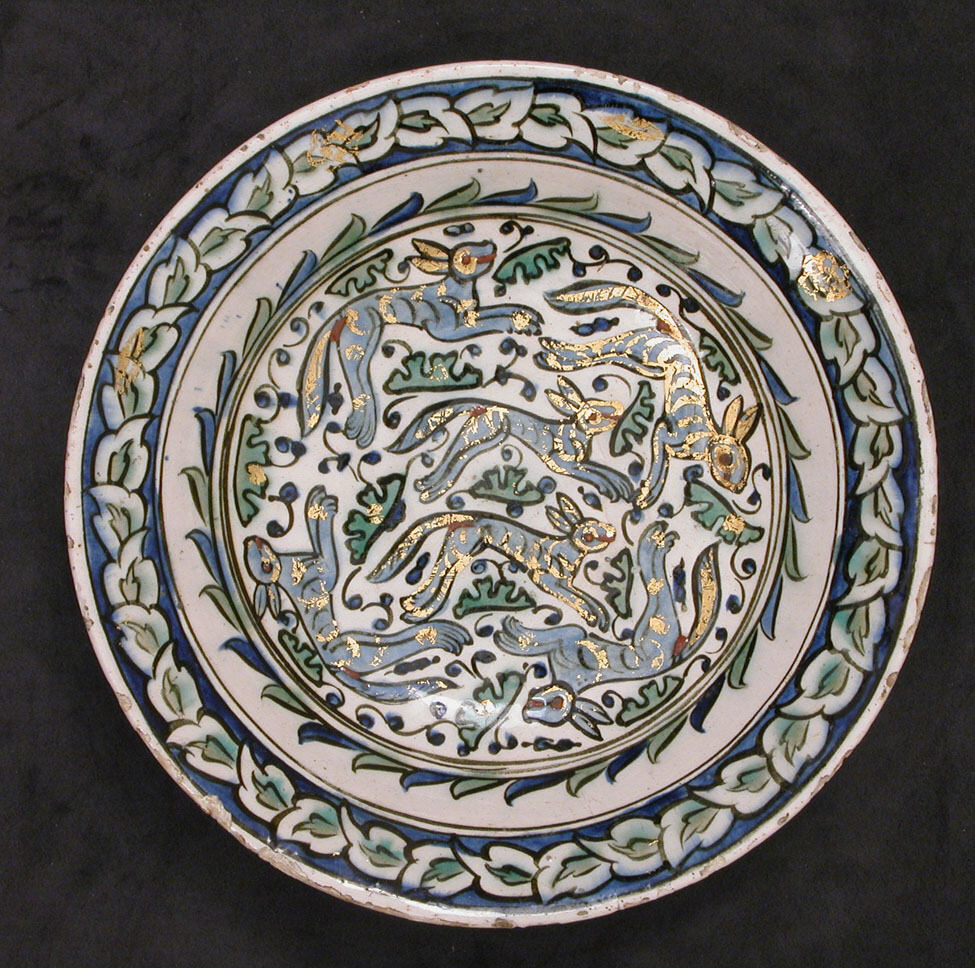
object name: dish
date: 1601-1700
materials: stonepaste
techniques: glazing, painting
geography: turkey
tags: rabbits